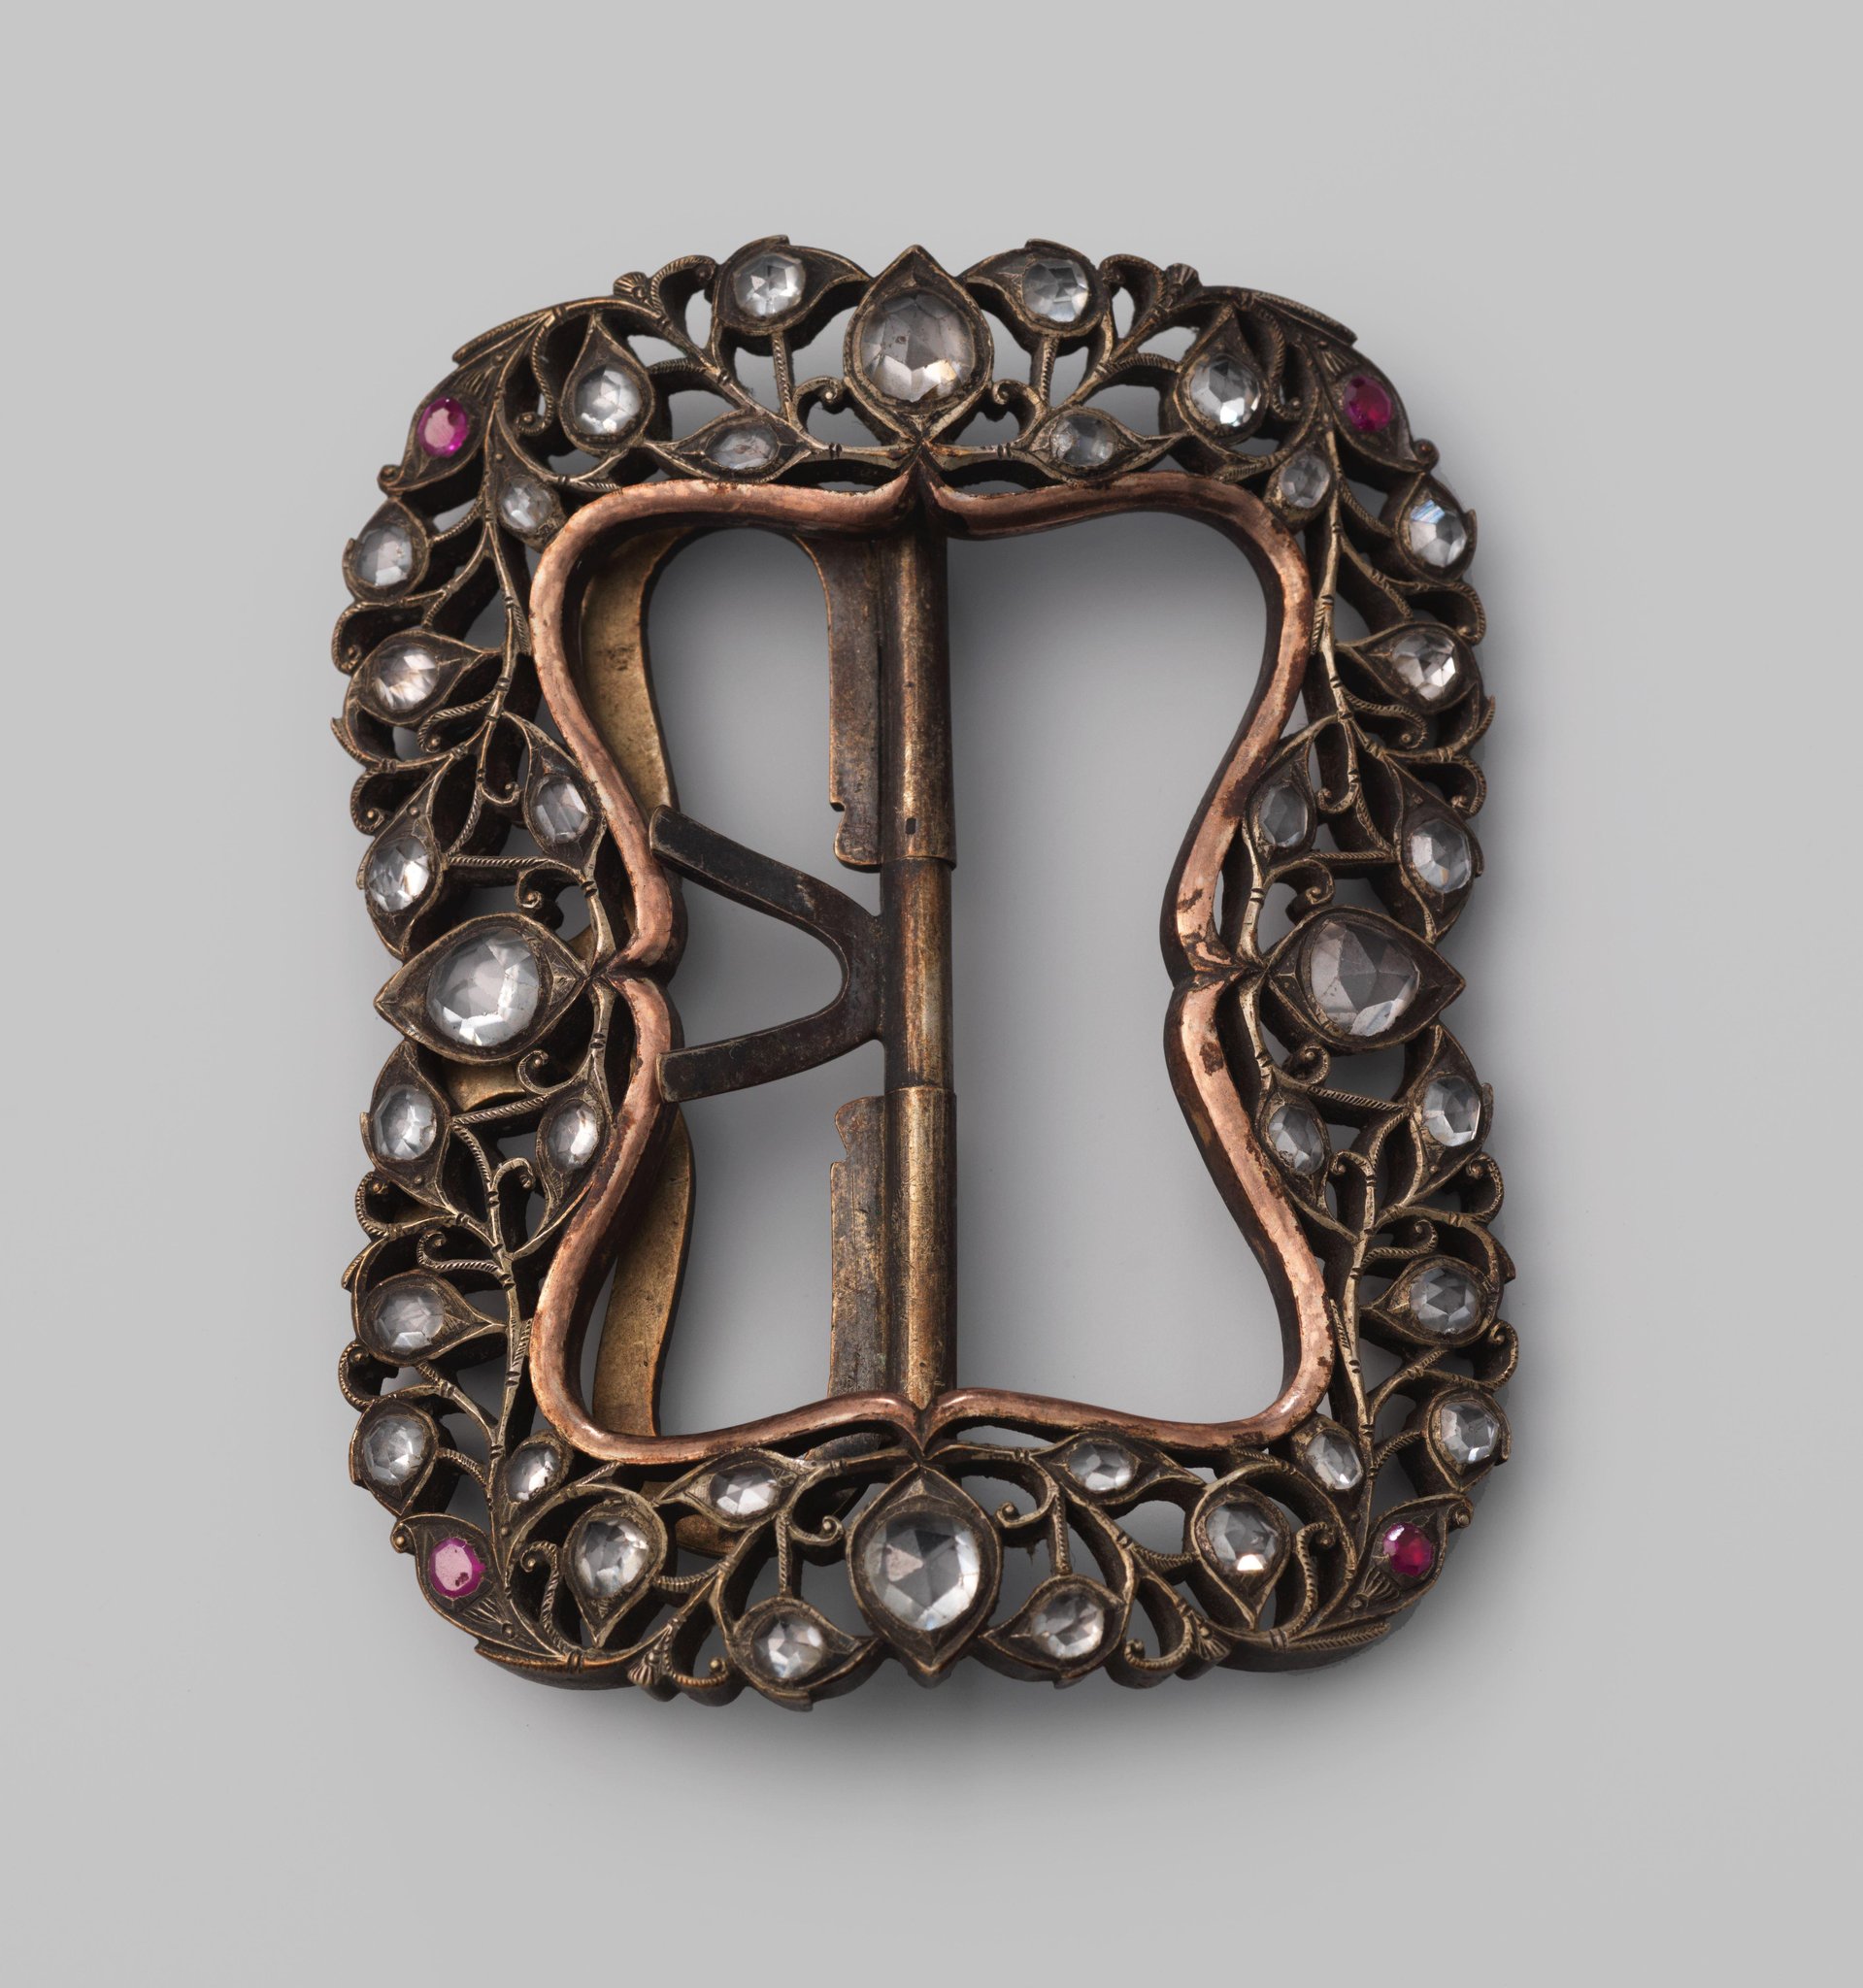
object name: buckle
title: Ceintuurgesp van zilver en koper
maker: Anonymous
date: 1850-1900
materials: copper, glass, silver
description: Ceintuurgesp van zilver en koper, geheel bezet met geslepen kleurloos en rood glas.